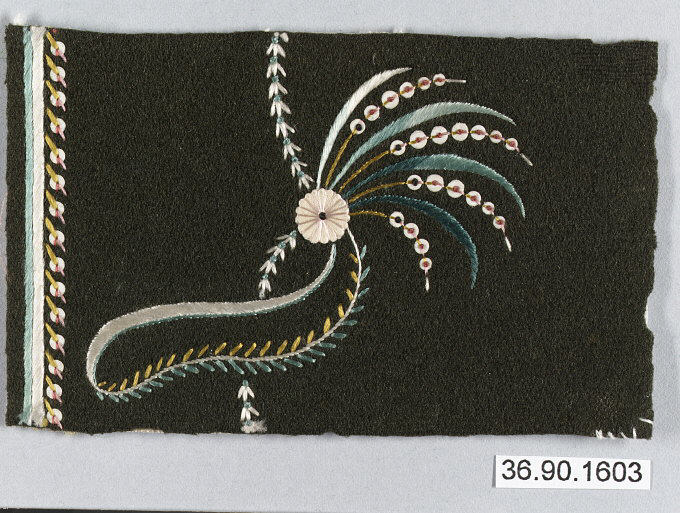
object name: sample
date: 1801-1833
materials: felt, silk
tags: flowers